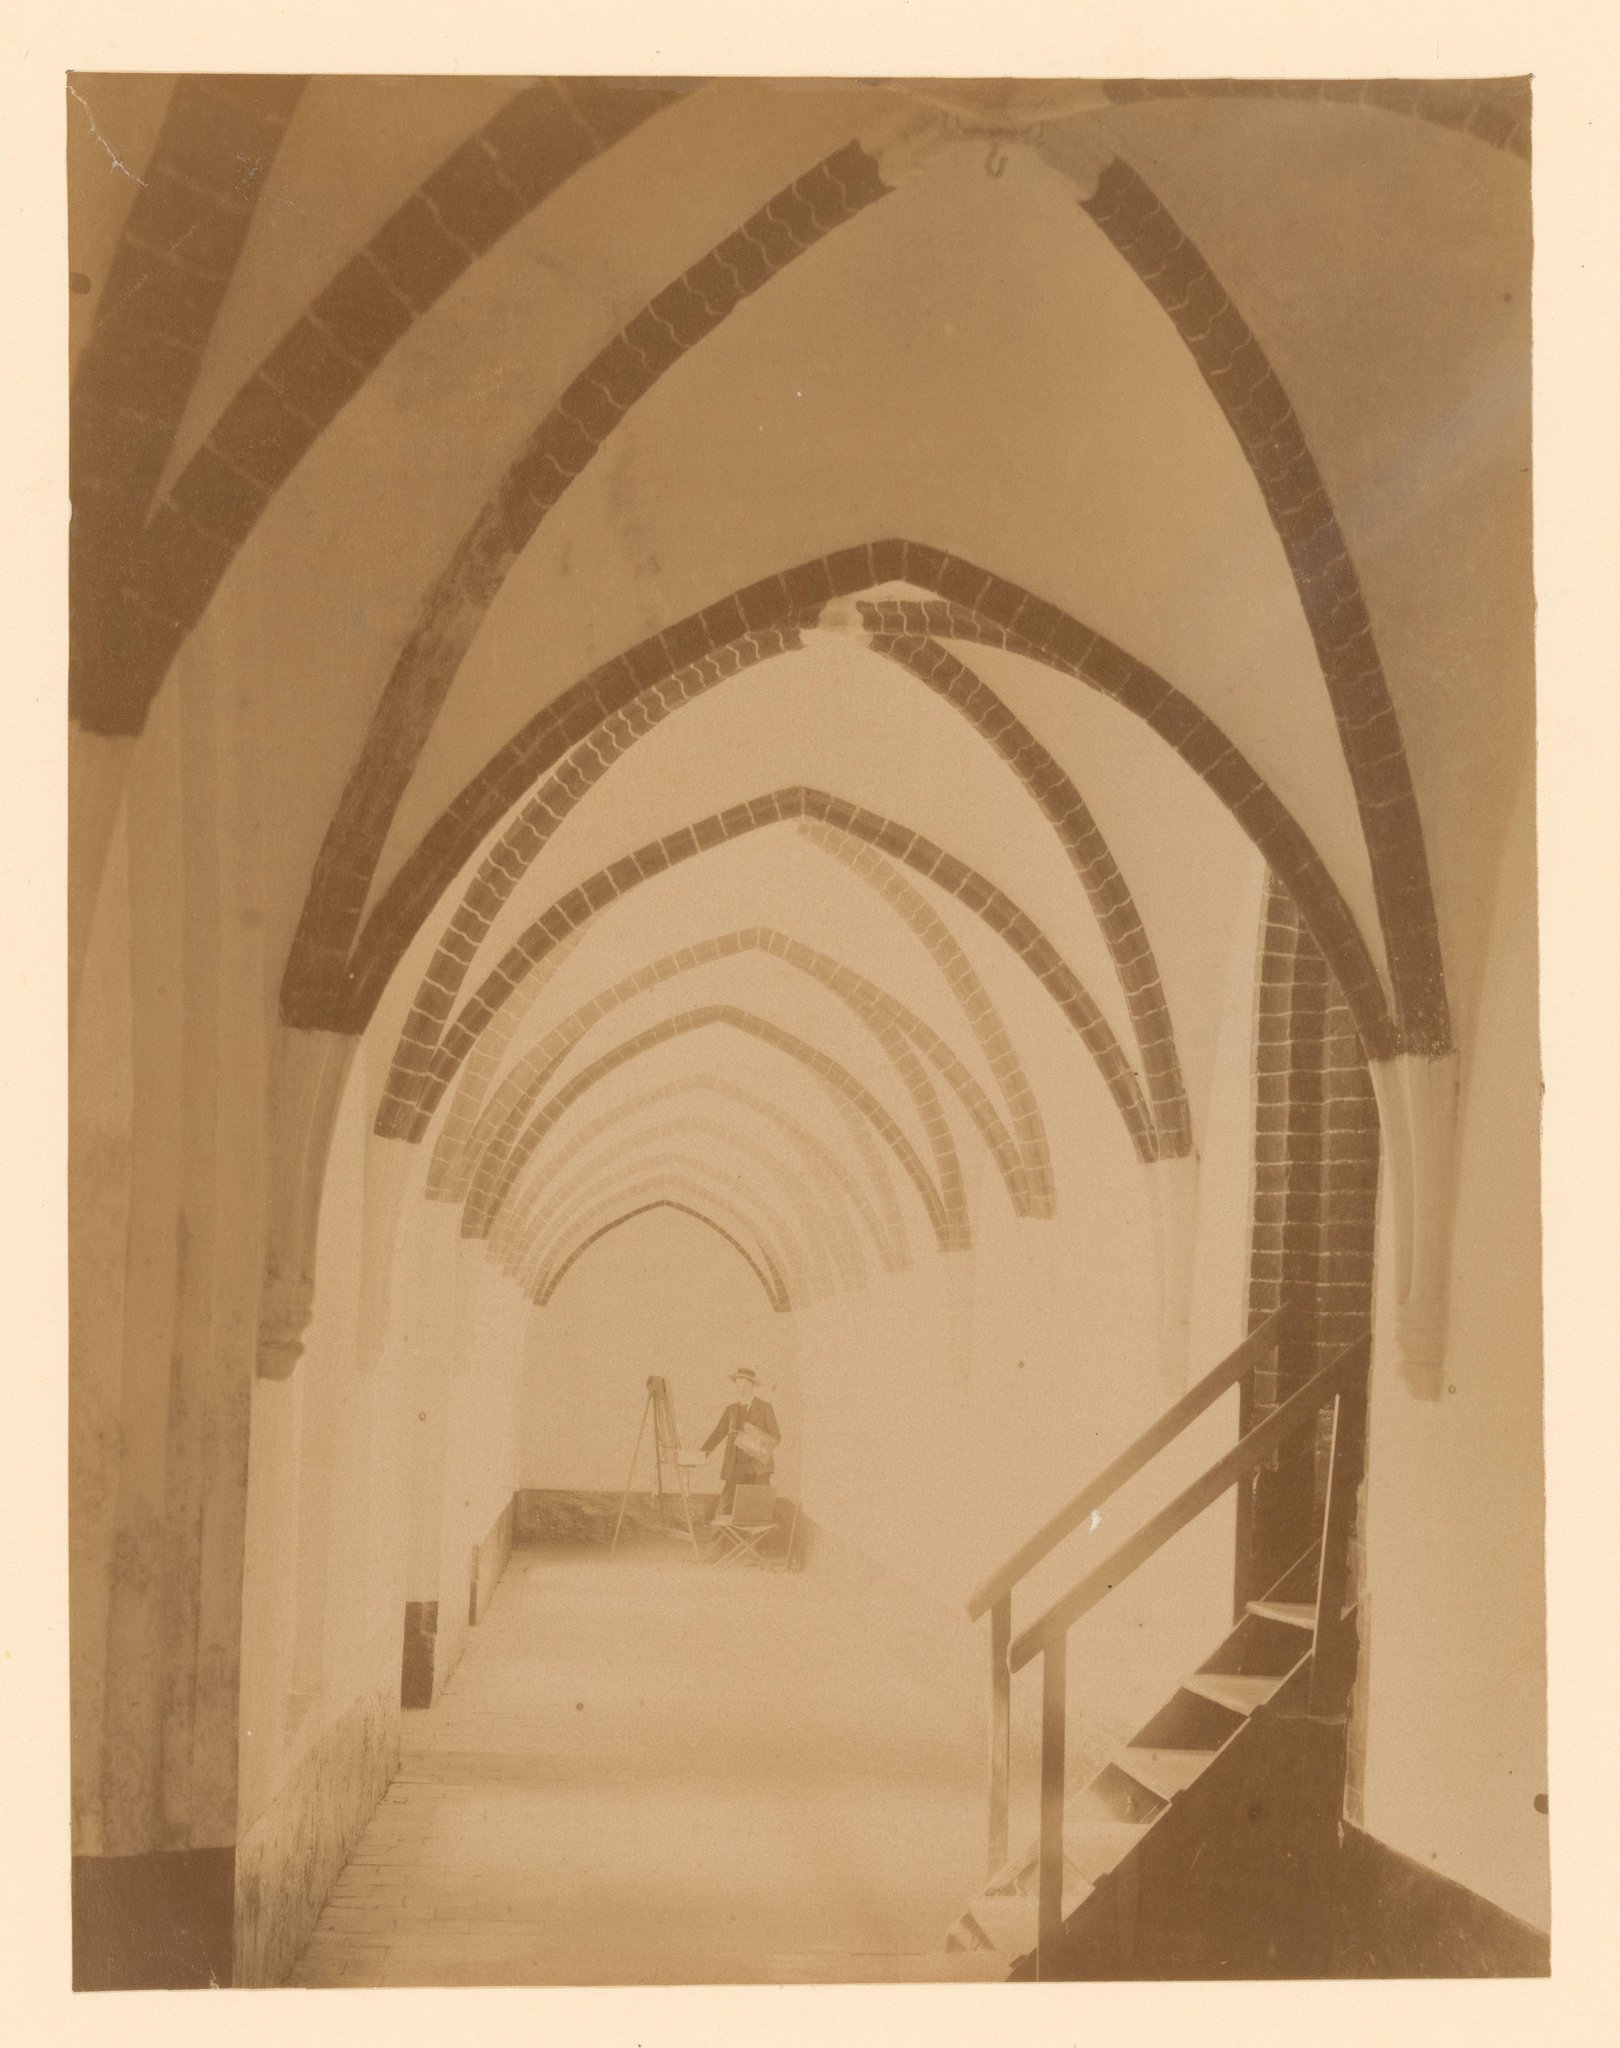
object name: photograph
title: Kloostergang met een kunstschilder in het Klooster Ter Apel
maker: anoniem (monumentenzorg)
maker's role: fotograaf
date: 1893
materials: cardboard, photographic support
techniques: albumen print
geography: ter apel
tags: corridor, cloisters ~ monastery, painting (including book-illumination, miniature-painting) (+ artist at work)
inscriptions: annotation: ‘Ter Apel/ Kloostergang ten noorden van den binnenplaats gezien naar het westen/ sept 1893’, annotation: ‘Ter Apel’